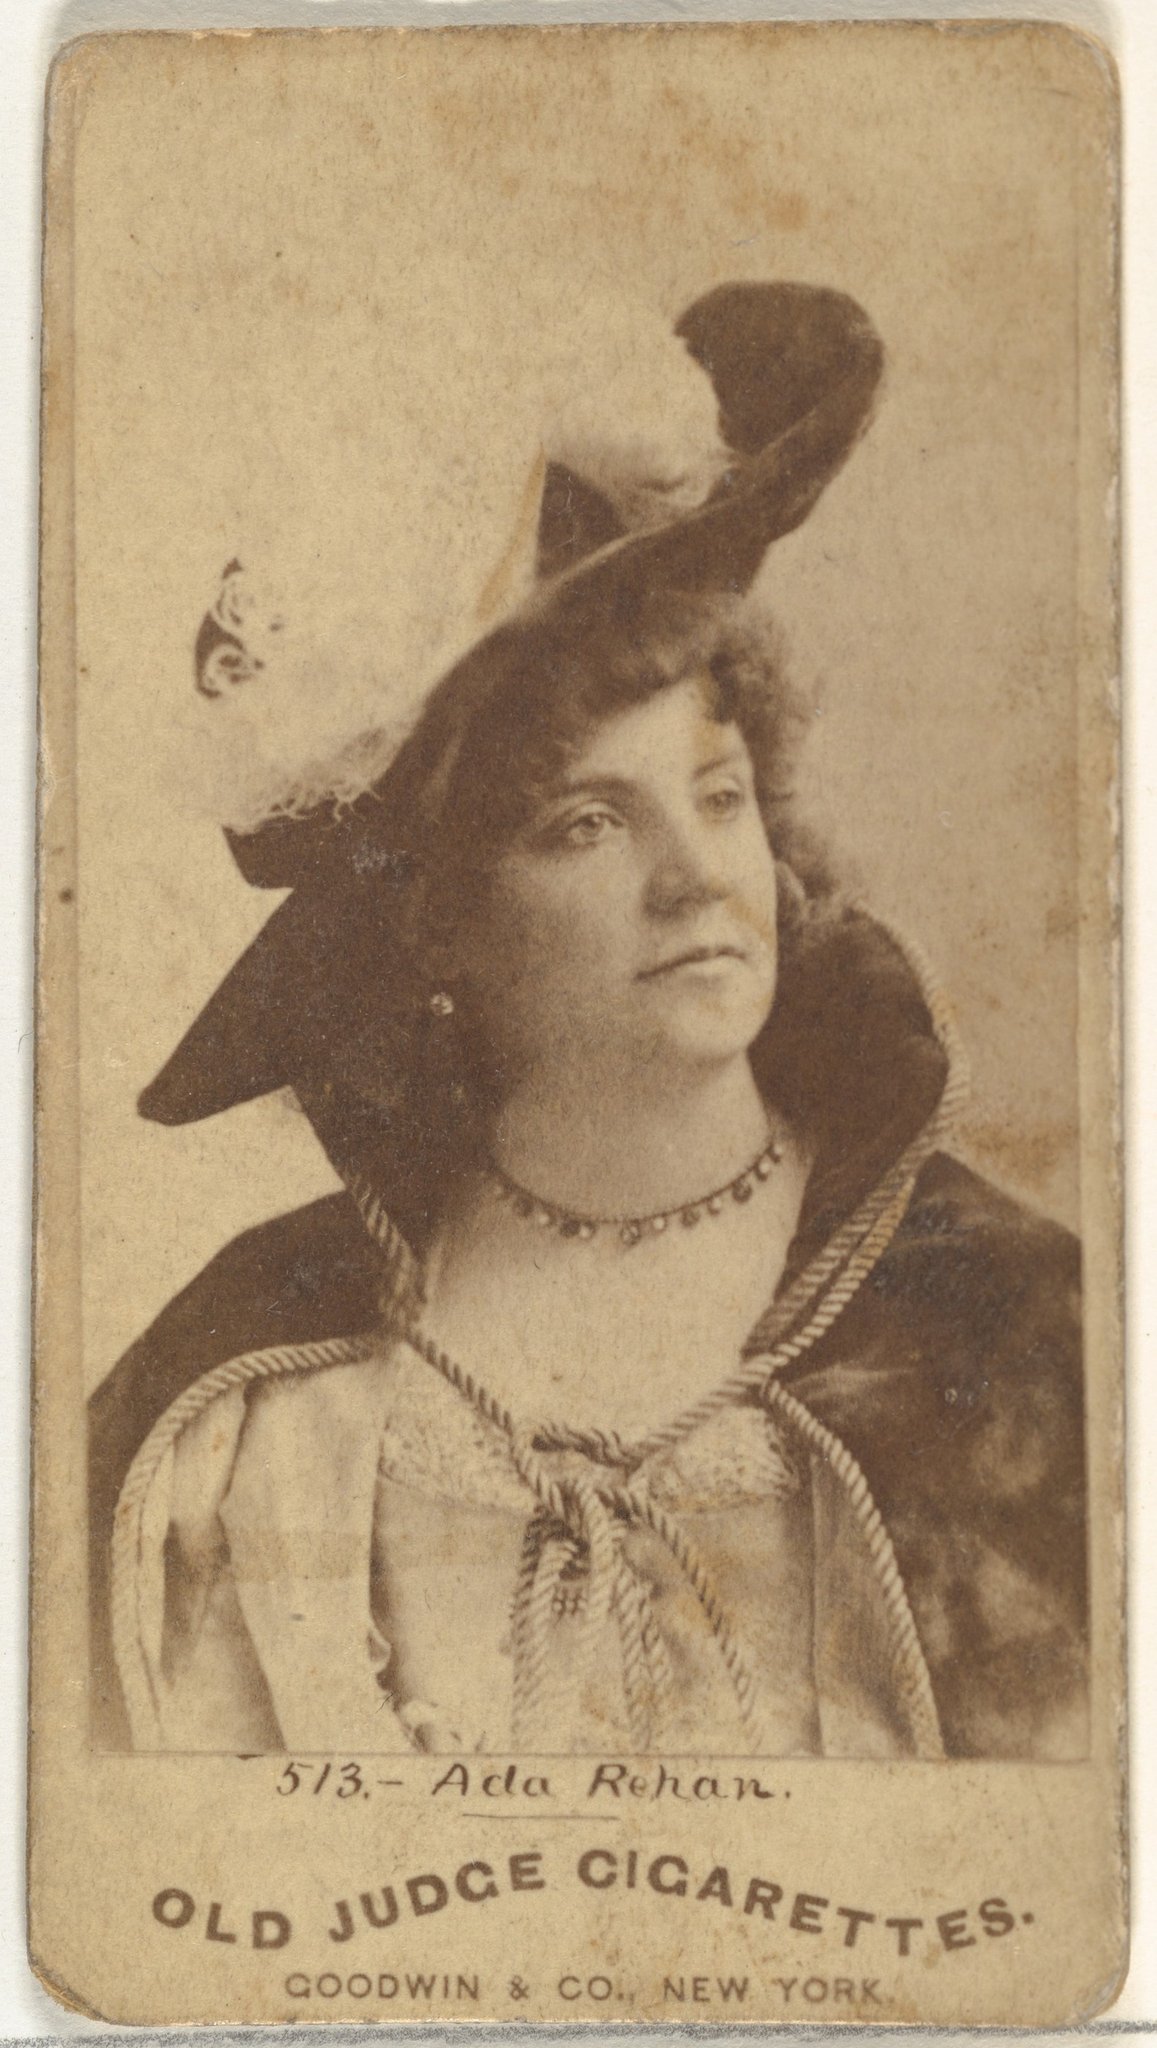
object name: photograph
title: Ada Rehan, from the Actors and Actresses series (N171) for Old Judge Cigarettes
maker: goodwin & company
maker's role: publisher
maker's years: 1850-1950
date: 1886-1890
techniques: albumen silver print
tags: portraits,women,actresses